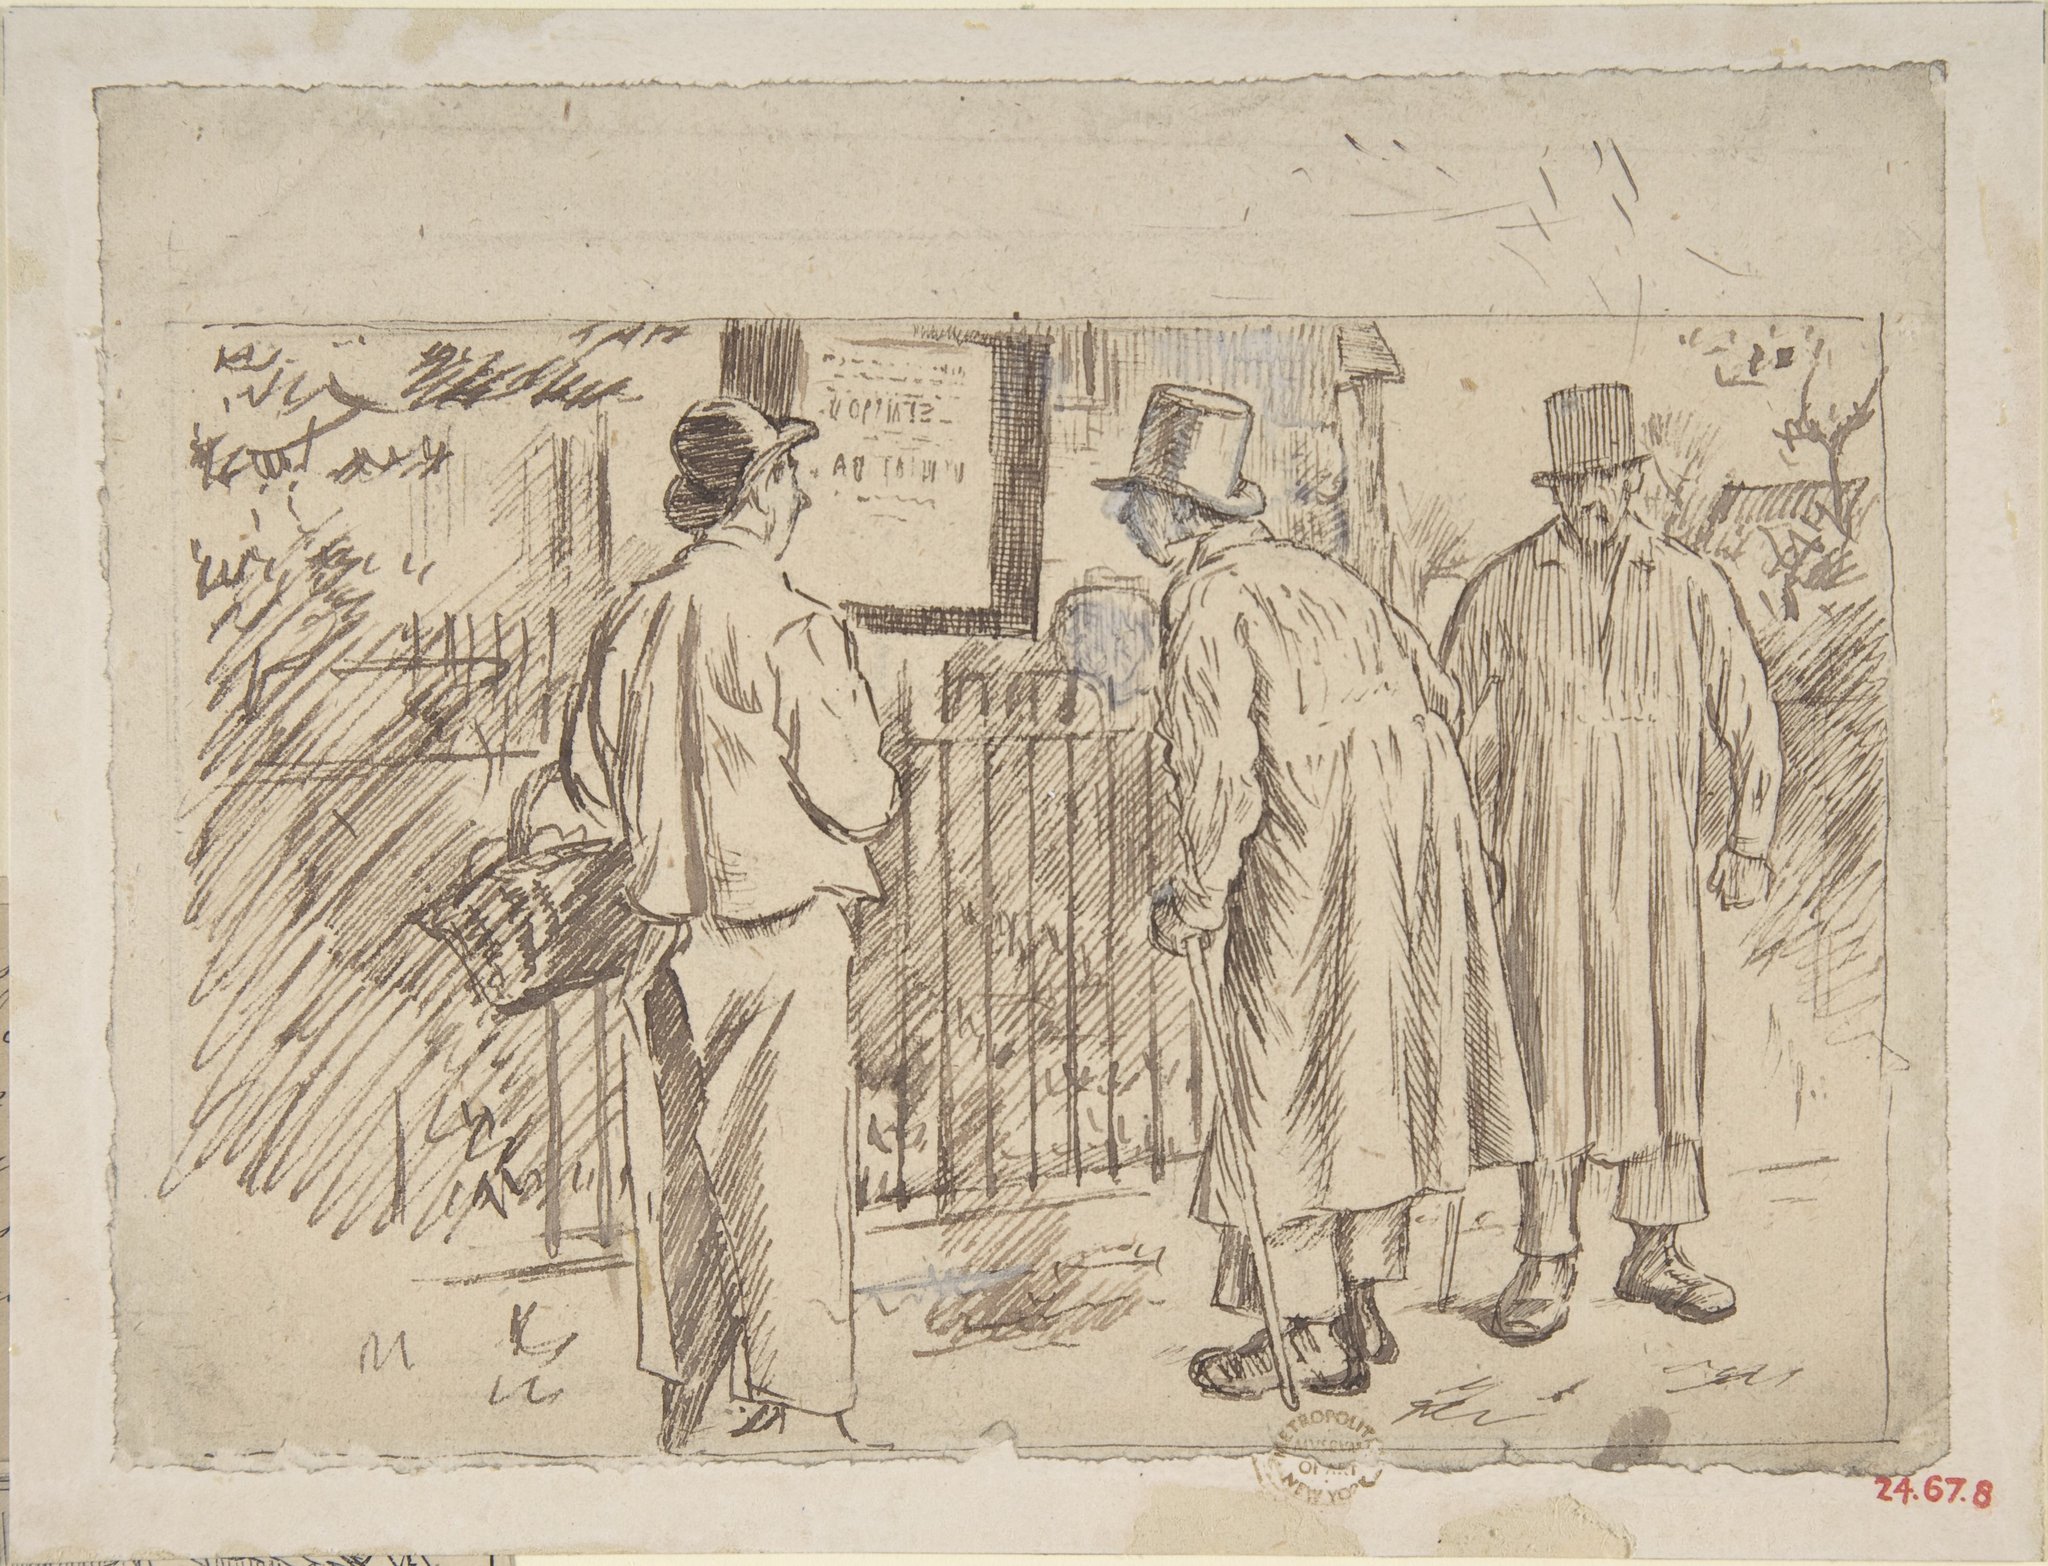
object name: drawing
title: "A Wolf in Sheep's Clothing"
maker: charles samuel keene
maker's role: artist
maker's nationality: british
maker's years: 1823-1891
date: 1870-1891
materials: gouache, ink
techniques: brush, pen, wash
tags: men